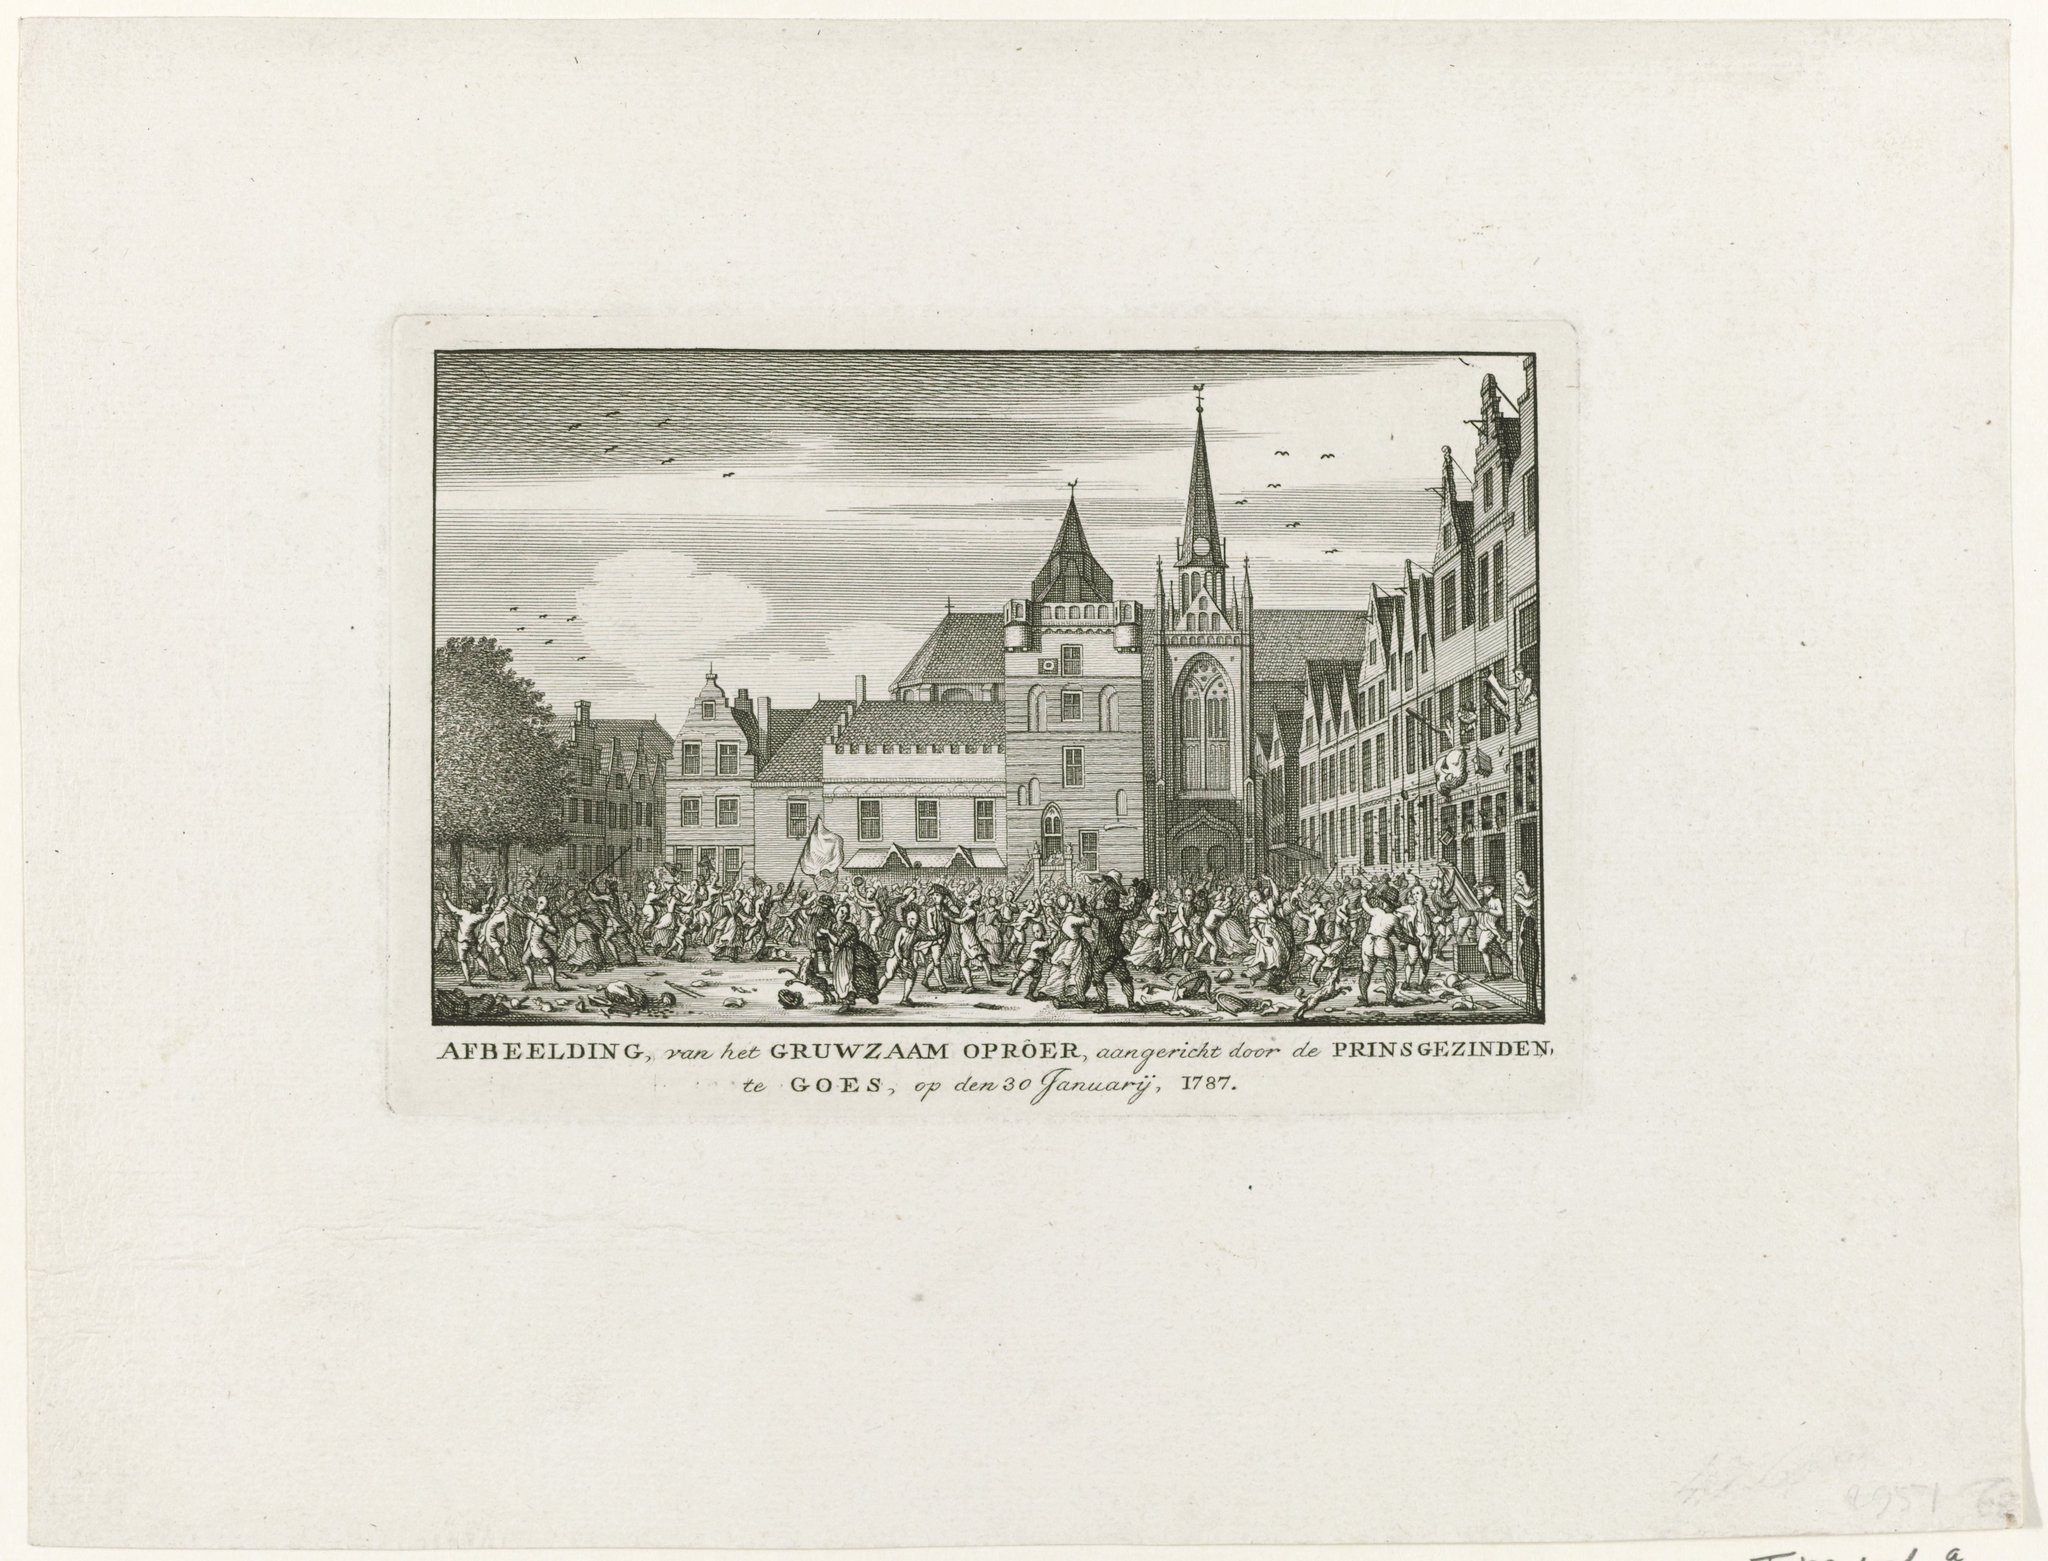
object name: print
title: Oproer door Prinsgezinden op de markt te Goes, 1787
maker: Anonymous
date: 1787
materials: paper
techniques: engraving, etching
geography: northern netherlands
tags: street-fights, riots, patriots (1780-1795)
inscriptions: collector's mark: Lugt 2228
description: Het oproer aangesticht door Prinsgezinden op de markt te Goes, 30 januari 1787. Gezicht op de Markt met het stadhuis en de Grote Kerk.